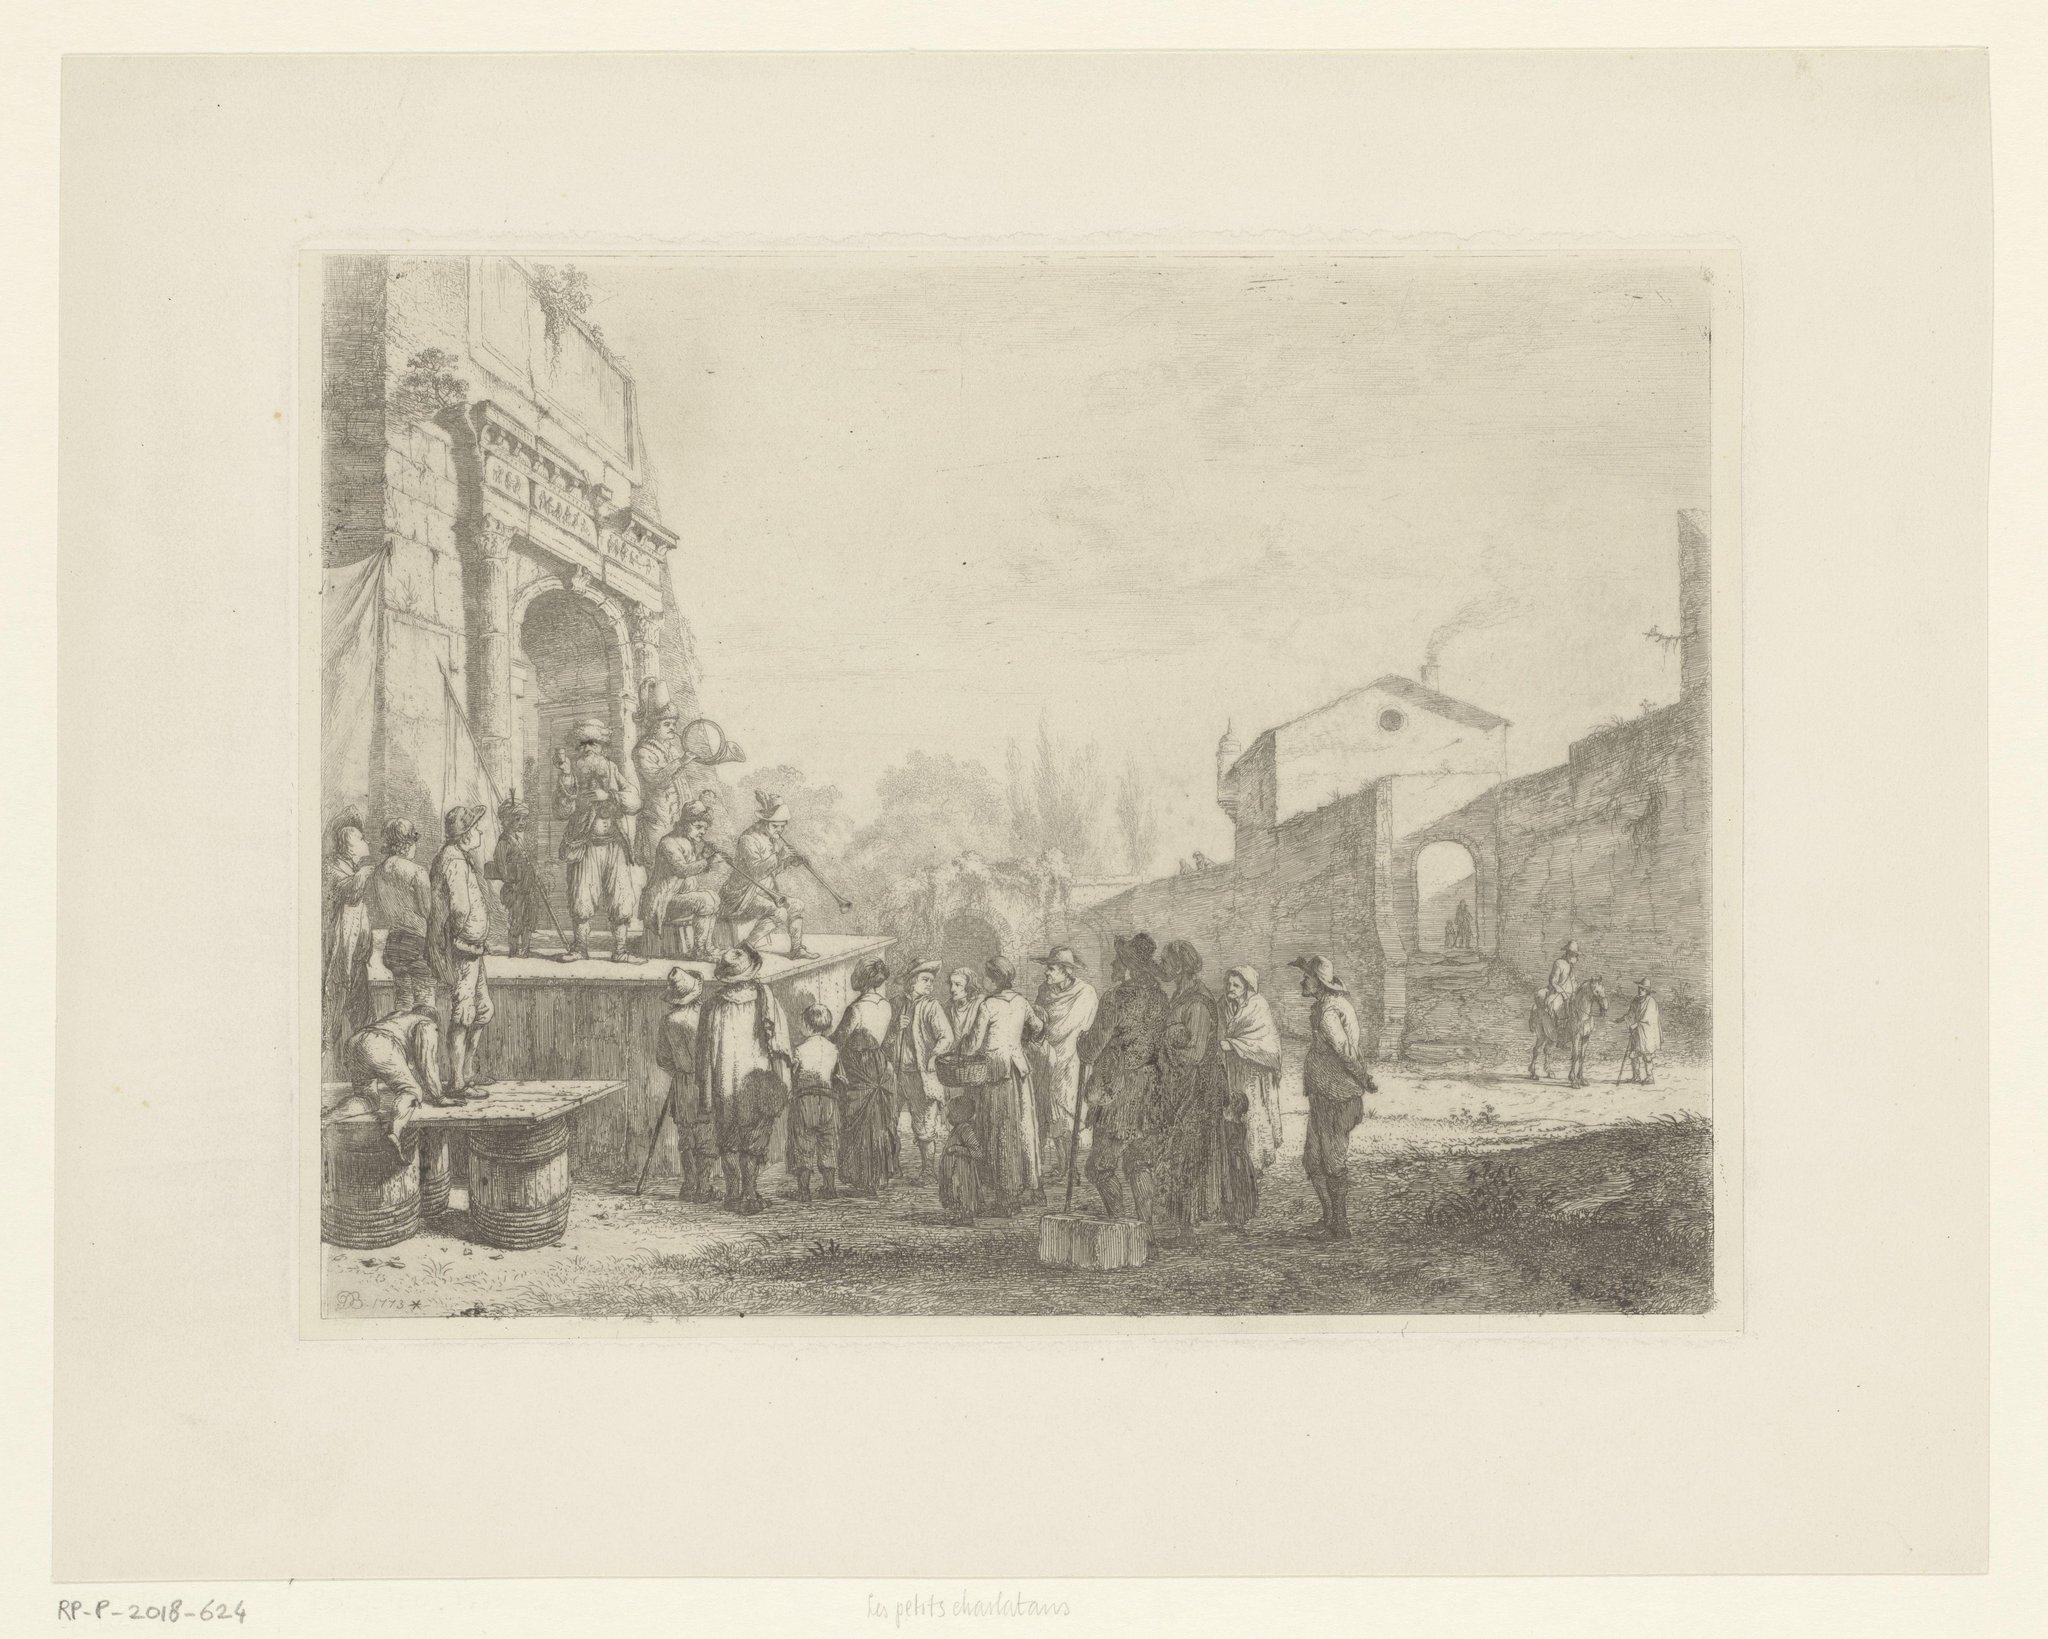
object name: print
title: Landschap met charlatans op een toneel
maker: jean jacques de boissieu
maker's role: draughtsman, print maker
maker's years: 1736-1810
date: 1773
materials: paper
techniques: etching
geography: france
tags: quack, charlatan, mountebank, 'saltimbanco', performance in the open air (pleasure fair)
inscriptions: collector's mark: Lugt 2228